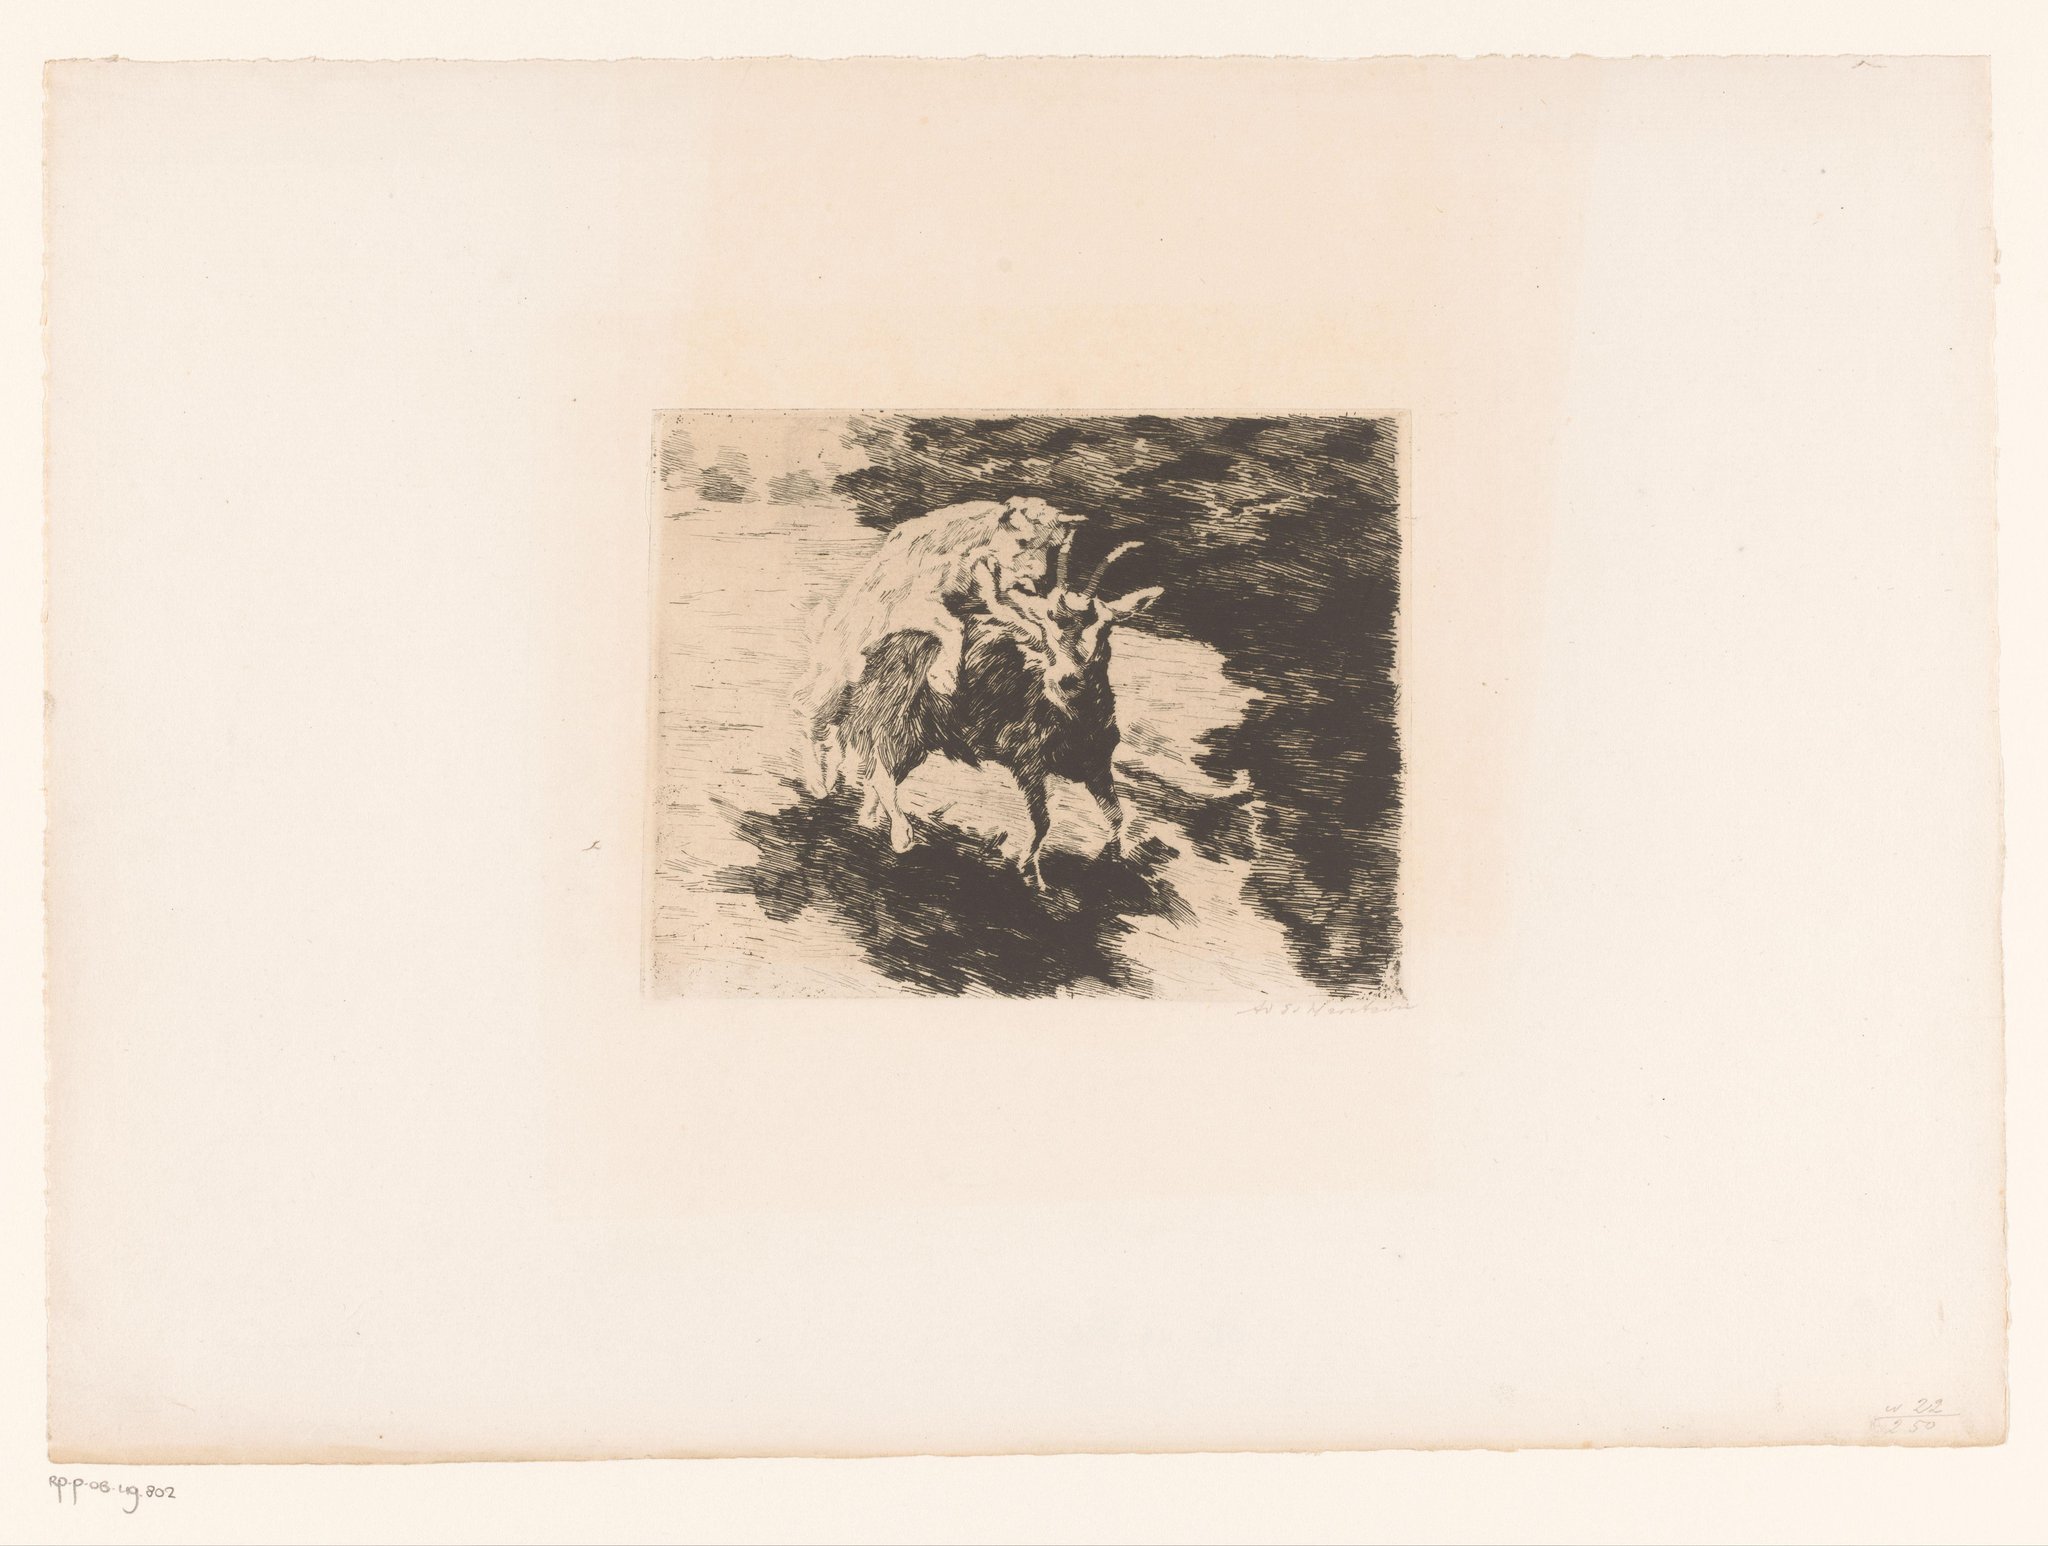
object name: print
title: Geit klimt op de rug van een bok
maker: adolf eduard herstein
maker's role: print maker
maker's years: 1869-1932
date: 1879-1932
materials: paper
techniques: drypoint, etching, intaglio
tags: goat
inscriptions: collector's mark: Lugt 2228